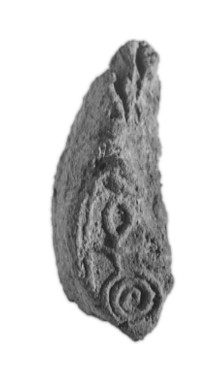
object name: sealing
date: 2030-1640 BCE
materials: clay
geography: egypt